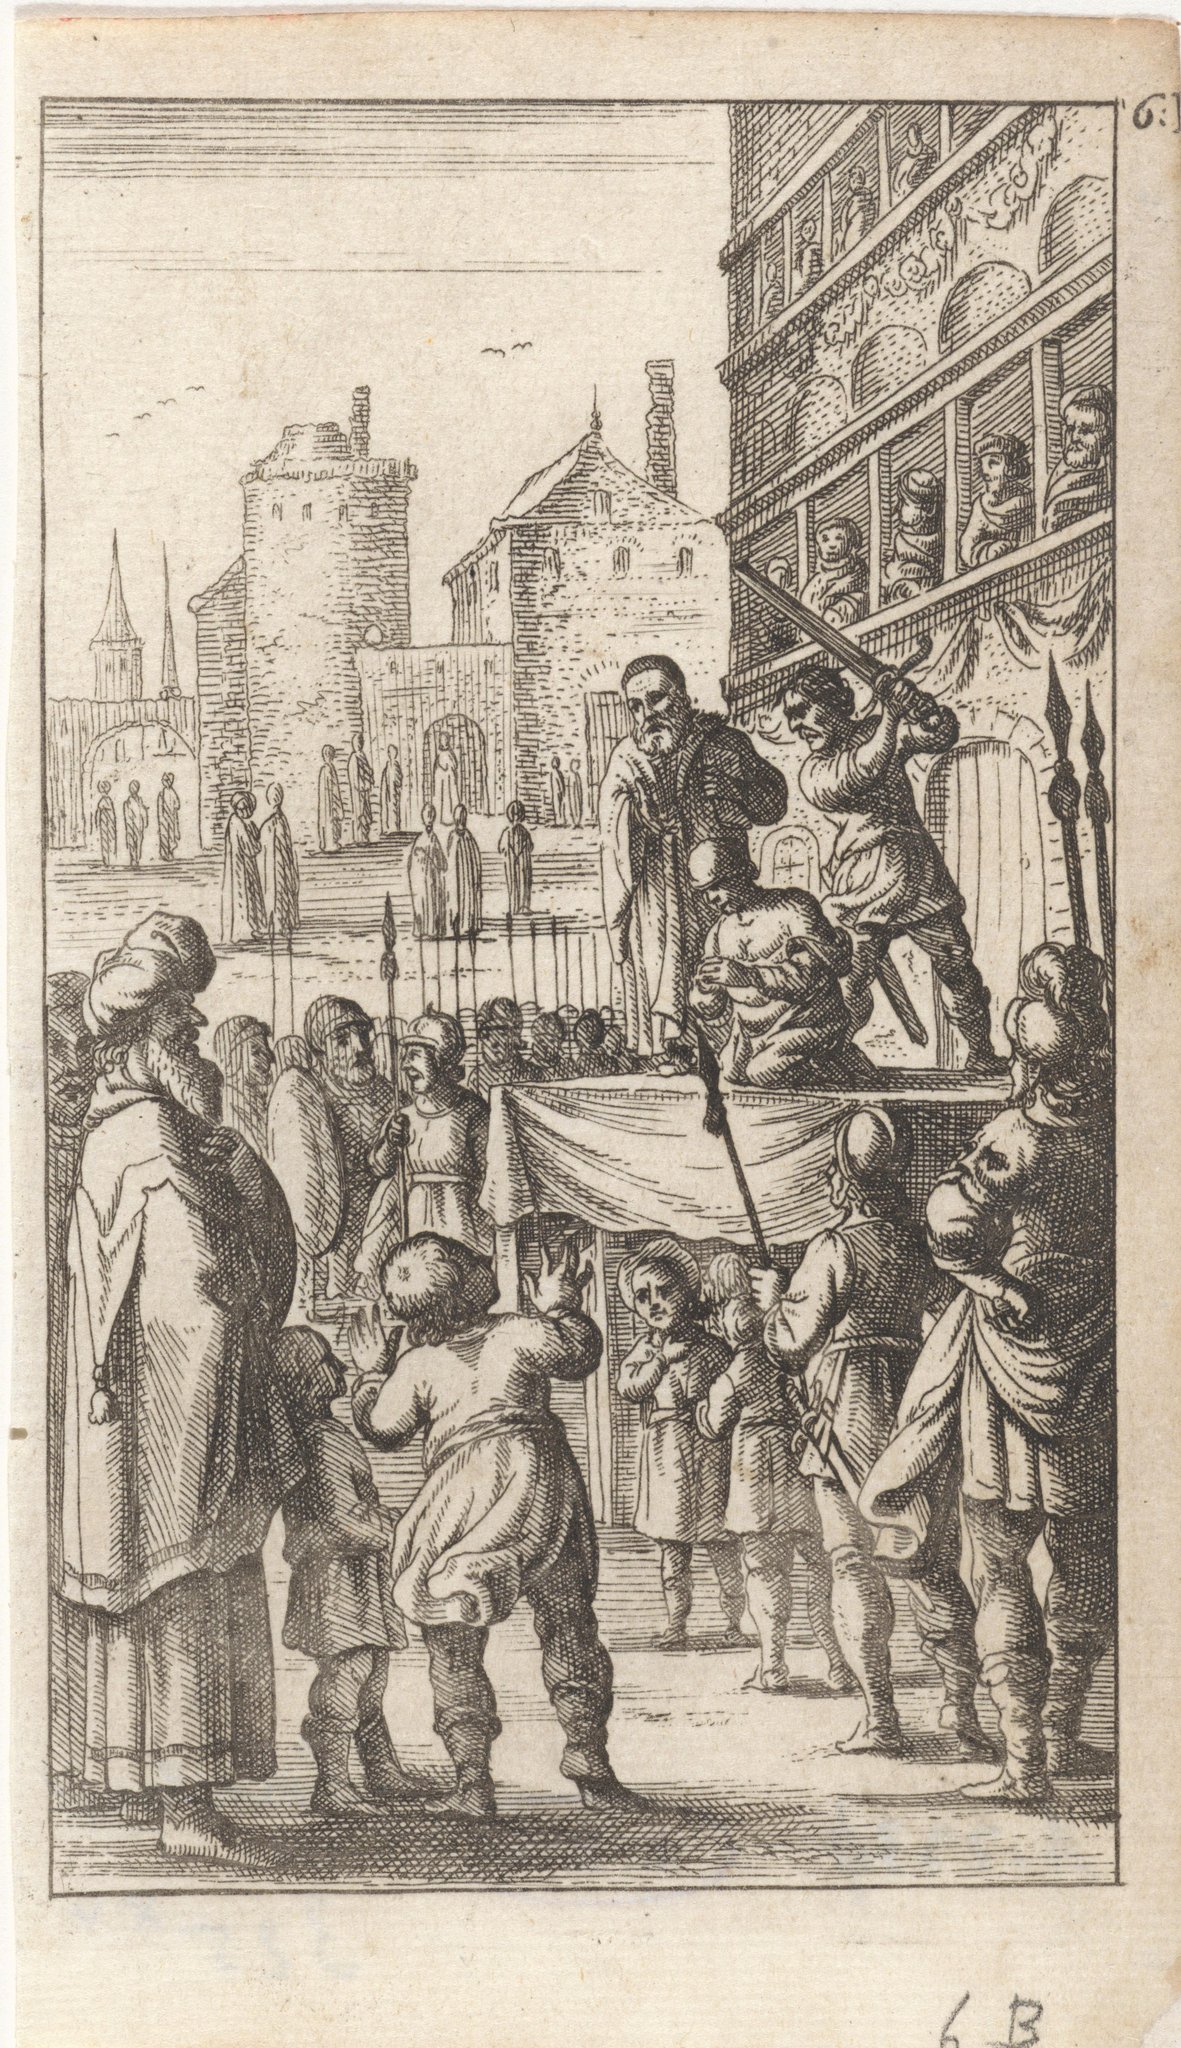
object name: print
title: Executie van een veroordeelde op een schavot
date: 1667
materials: paper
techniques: etching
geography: amsterdam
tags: castle, on the scaffold or place of execution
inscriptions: collector's mark: Lugt 2228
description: Rechts zit de veroordeelde op zijn knieën op een schavot. De beul achter hem staat met opgeheven zwaard klaar om hem te onthoofden. Naast de veroordeelde staat een geestelijke. Enkele kinderen, soldaten en hooggeplaatste personen kijken toe. Op de achtergrond een kasteel.